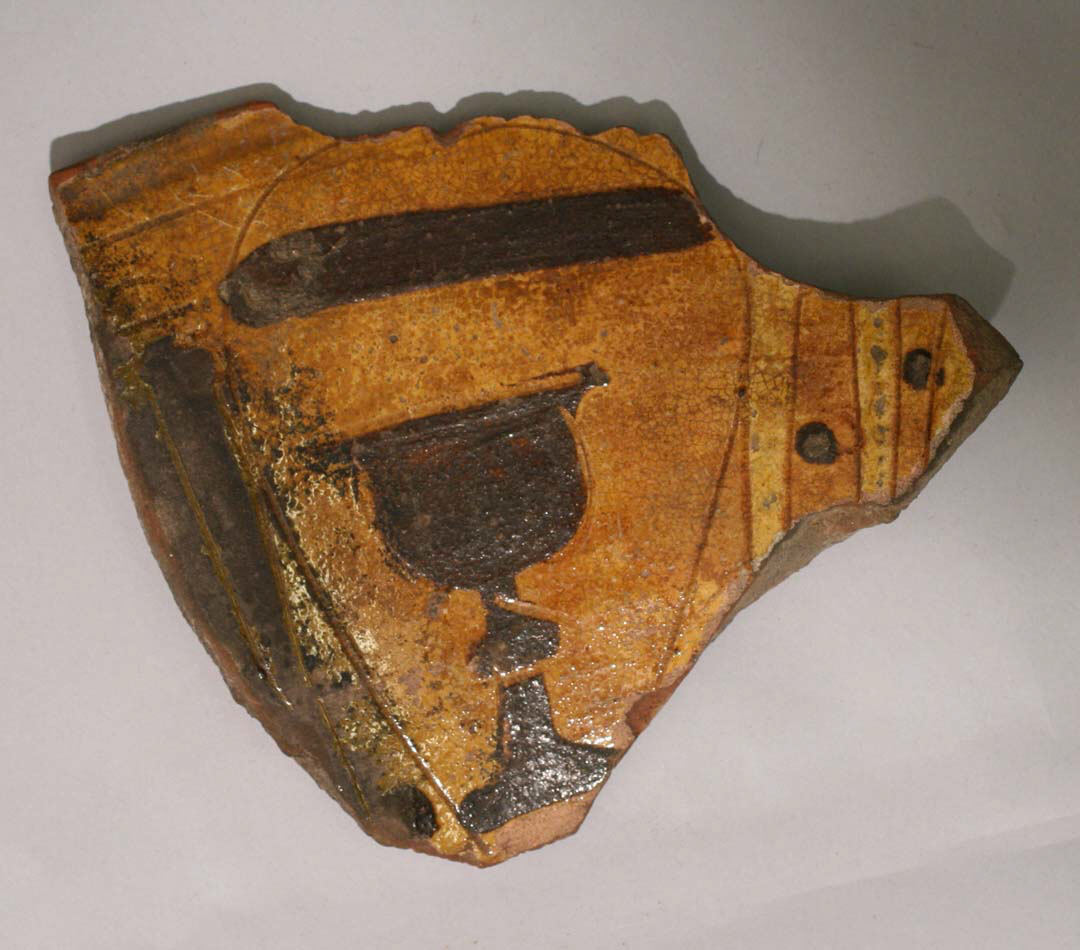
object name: ceramic fragment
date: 1301-1500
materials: earthenware, glaze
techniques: coloring, incising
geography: egypt